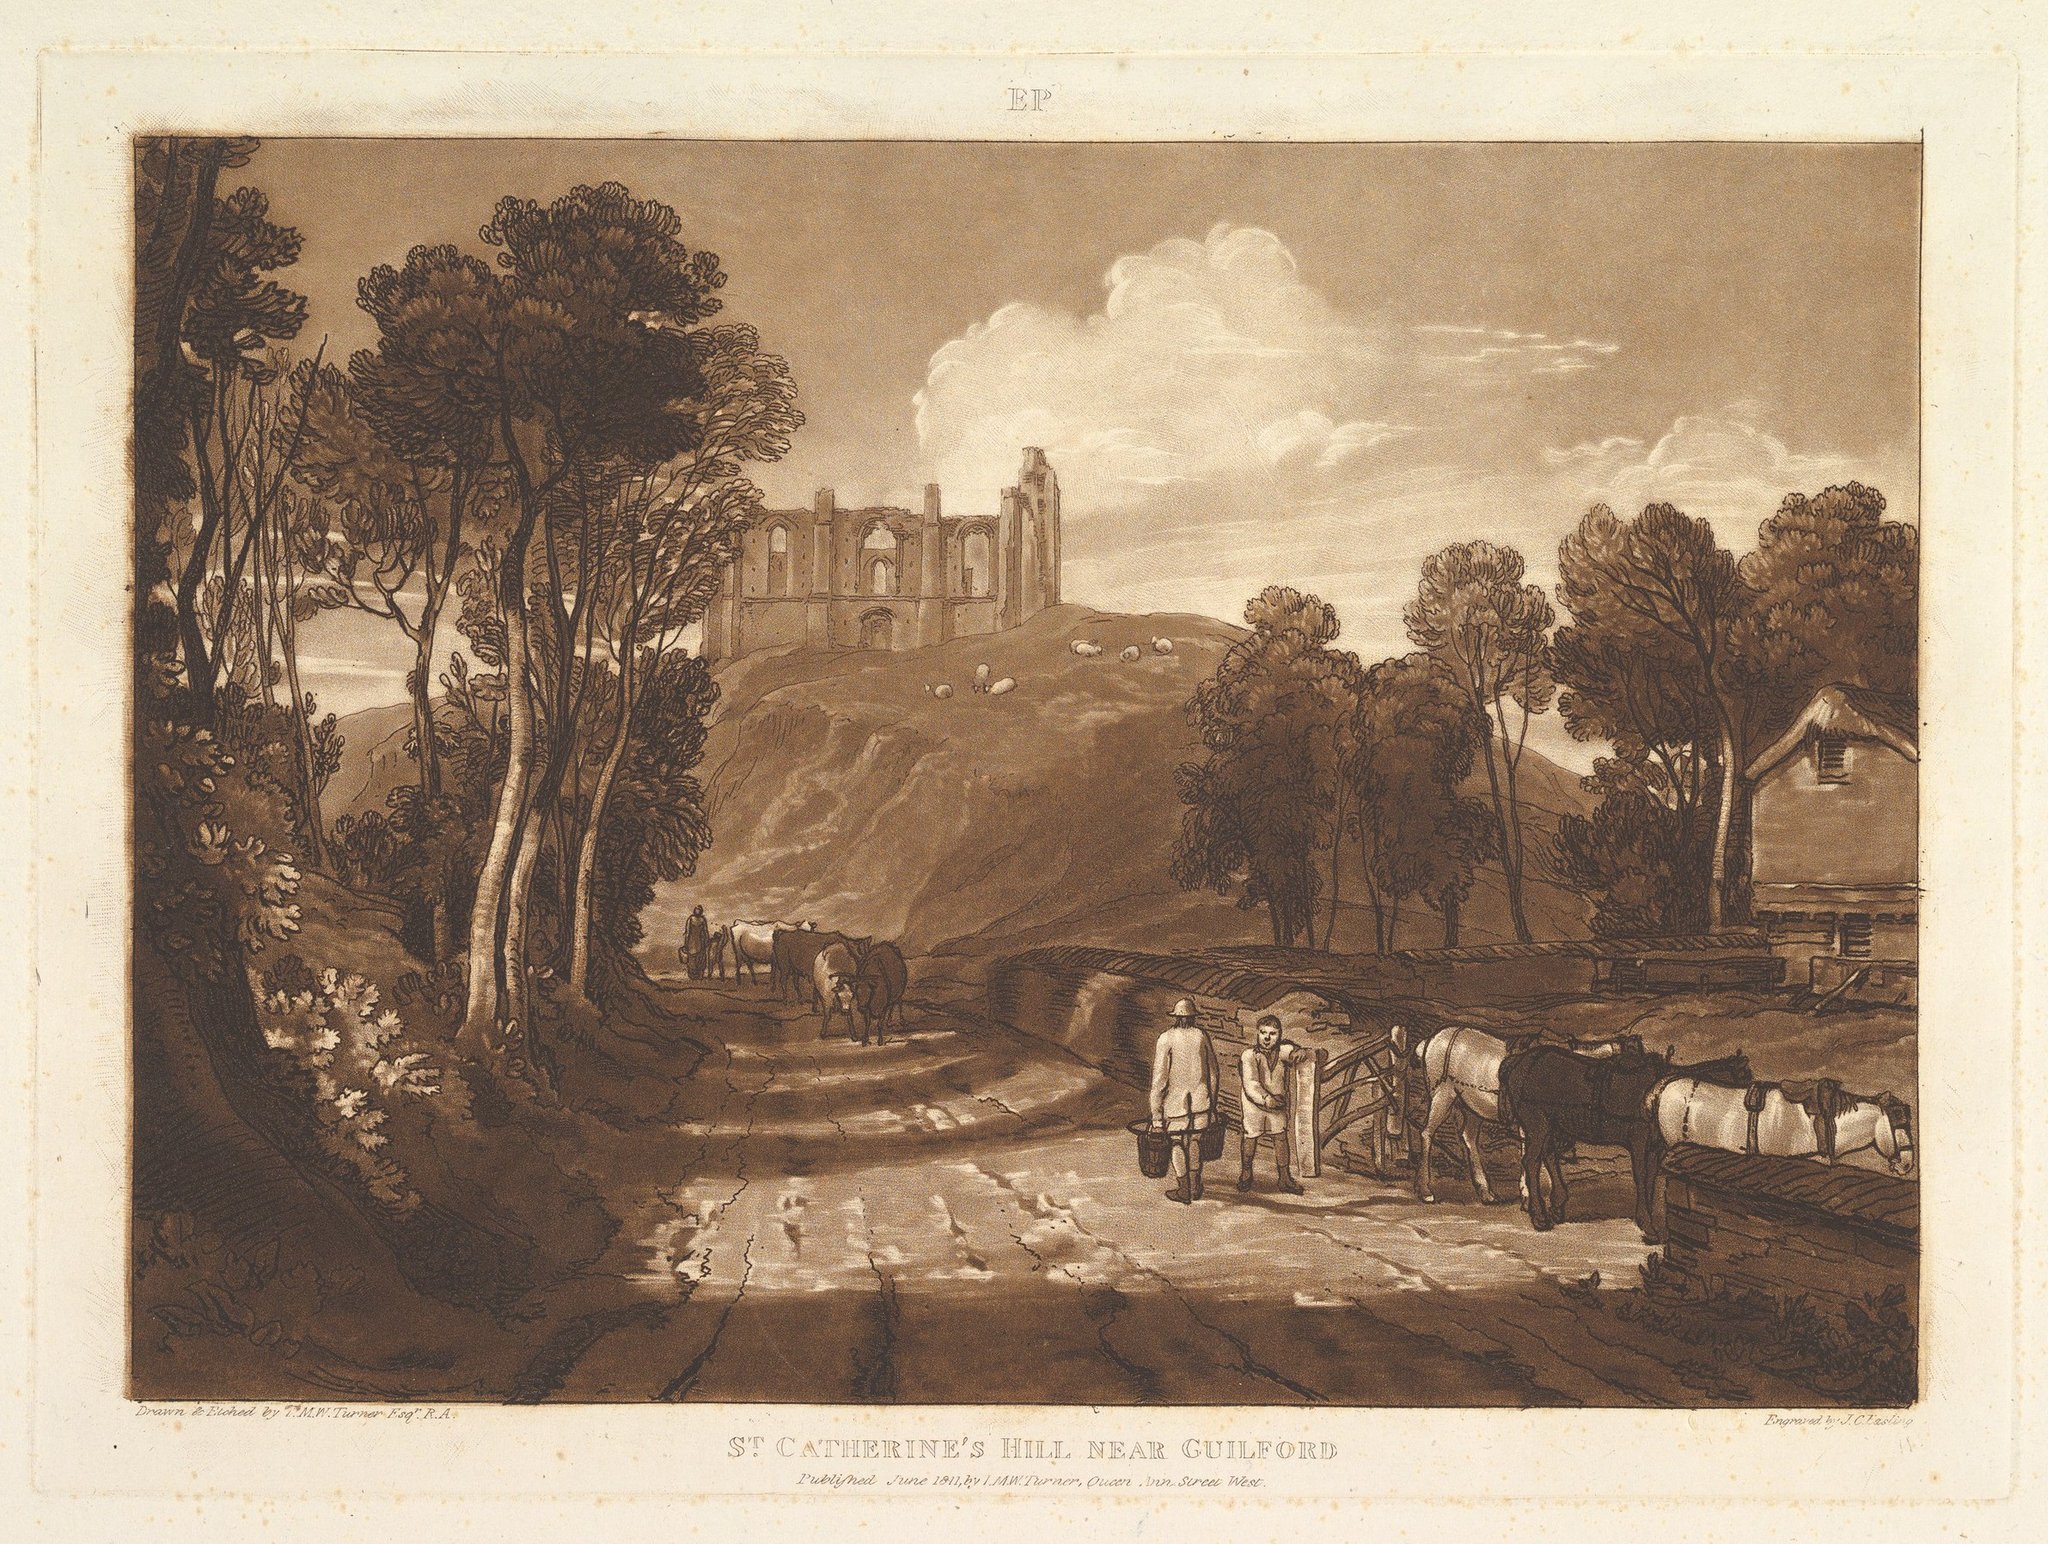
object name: print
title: St. Catharine's Hill near Guilford, part VII from "Liber Studiorum"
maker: joseph mallord william turner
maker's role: artist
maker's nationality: british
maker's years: 1775-1851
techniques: etching, mezzotint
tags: houses,roads,horses,hills,trees